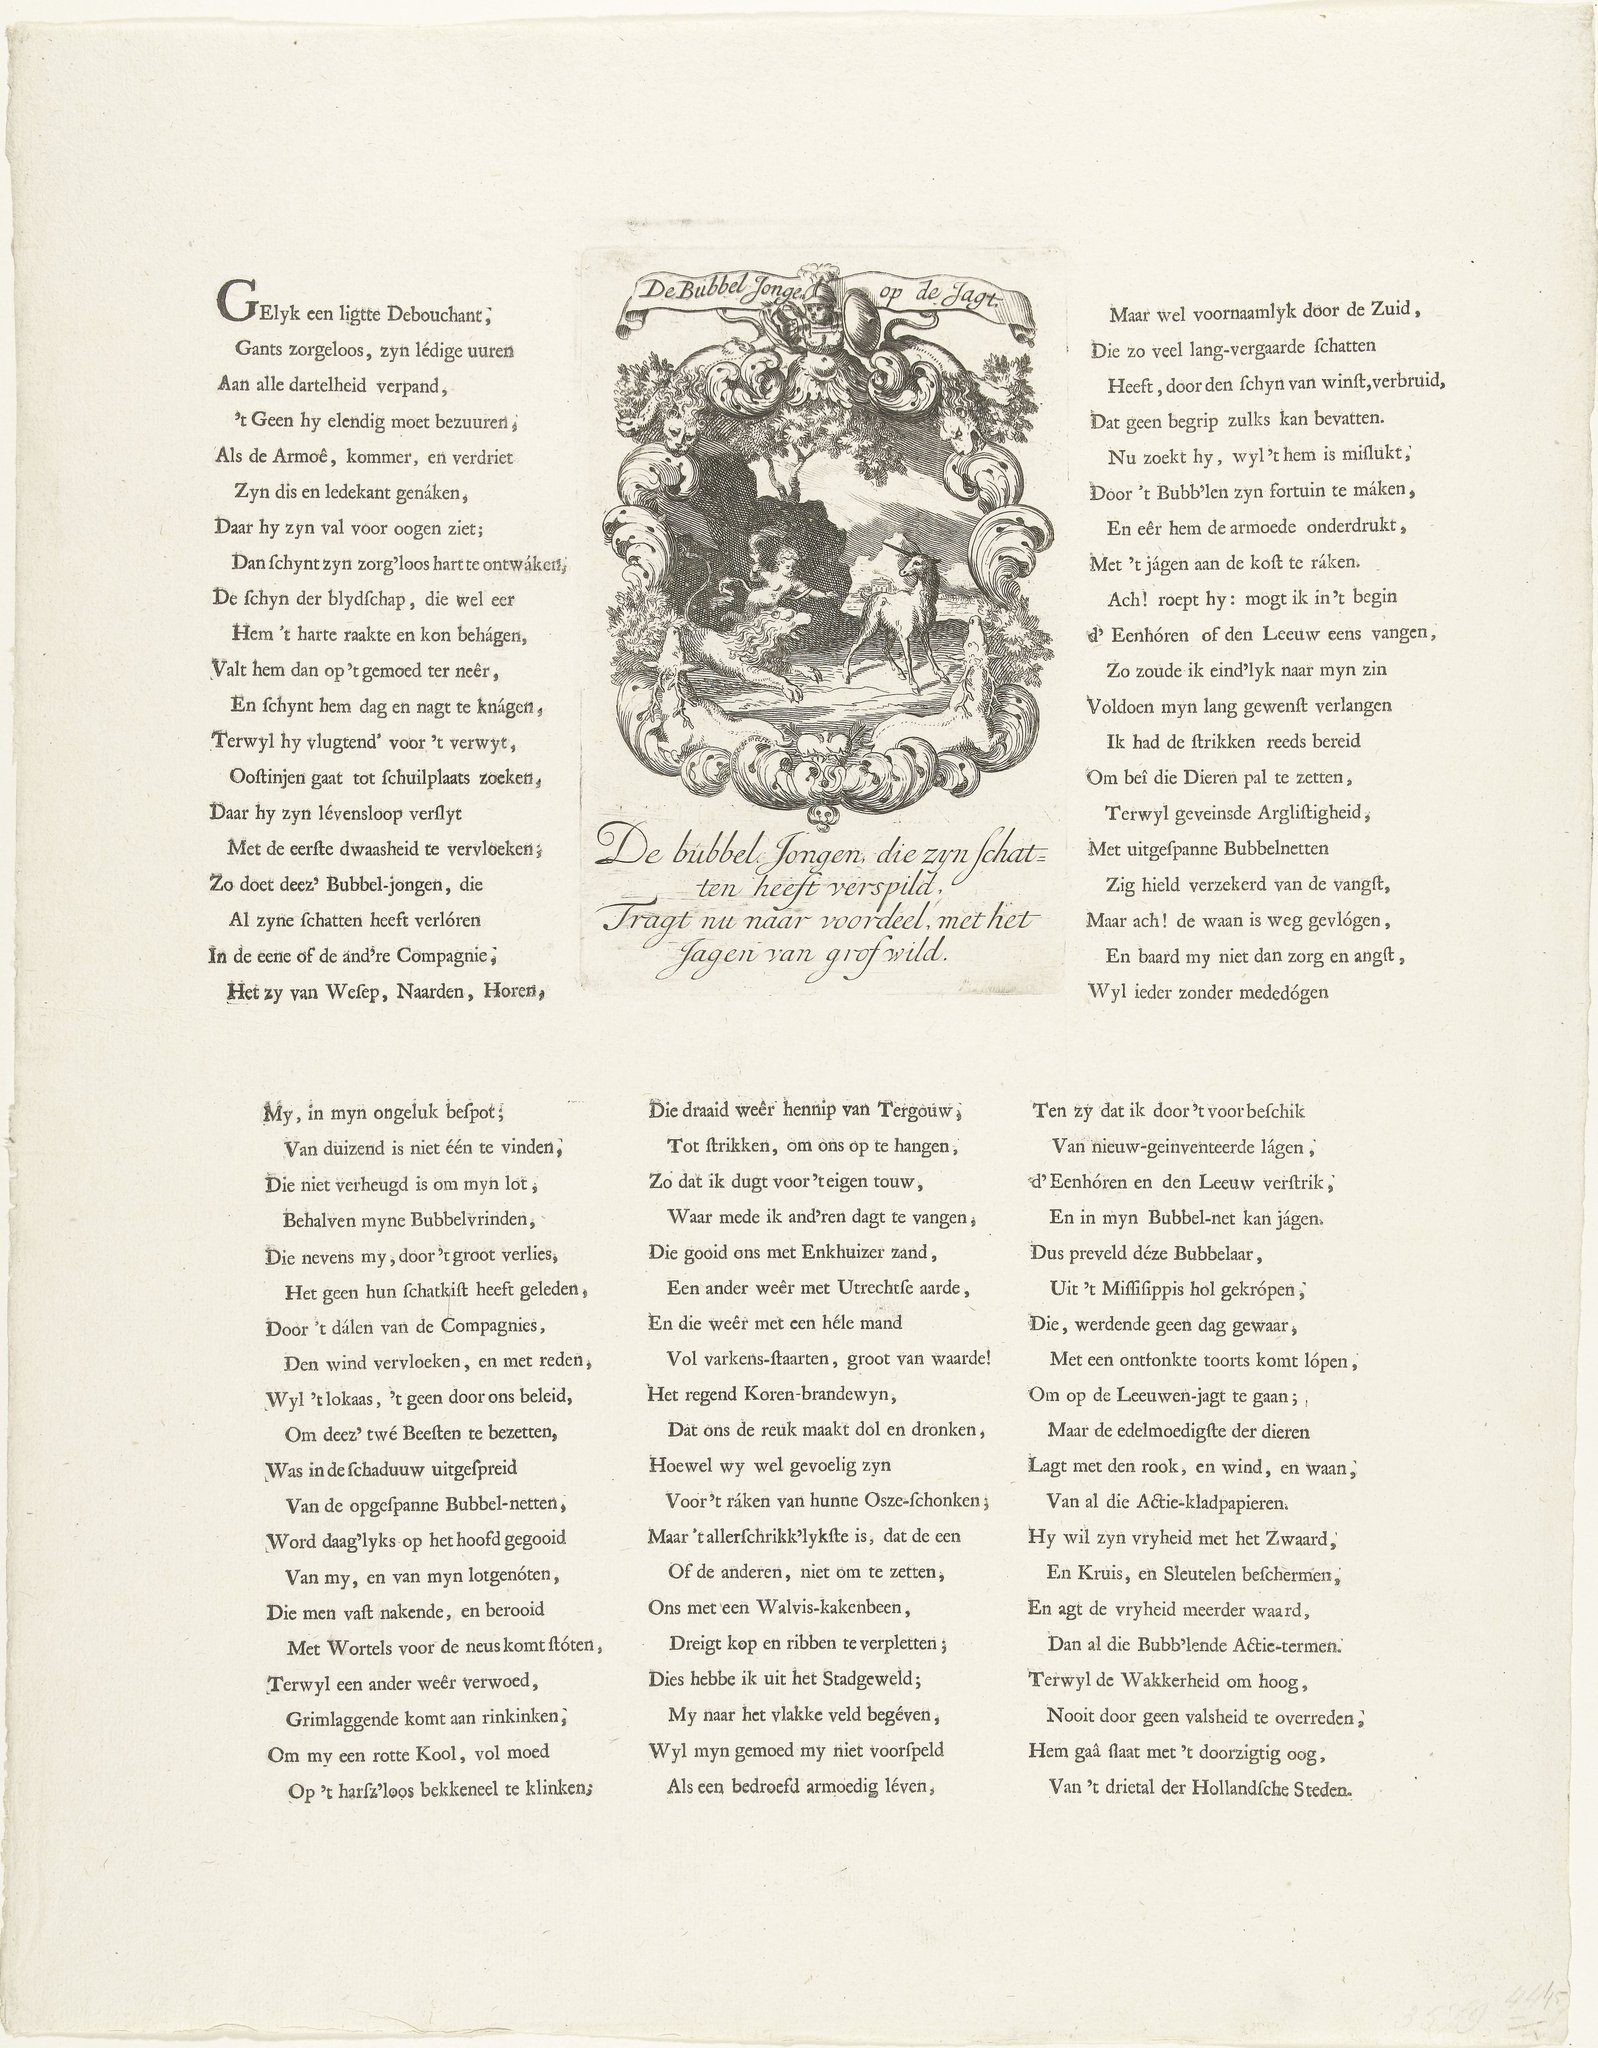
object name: cartoon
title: Het Groote Tafereel der Dwaasheid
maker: pieter van den berge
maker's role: draughtsman, print maker, printer, publisher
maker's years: 1659-1737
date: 1697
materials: paper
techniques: engraving, etching, letterpress printing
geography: northern netherlands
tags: unicorn, hunting, chase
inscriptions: collector's mark: Lugt 2228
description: De Bubbeljongen op jacht. Een door de windwandel berooide naakte jongen jaagt met een fakkel op een leeuw en eenhoorn. In een decoratieve omlijsting met leeuwen en herten. In het onderschrift een vers van vier regels. Gedrukt op het blad om en onder de plaat staan vijf verzen. Prent 44 in de serie Het Groote Tafereel der Dwaasheid met spotprenten op de Windhandel of Actiehandel van 1720.